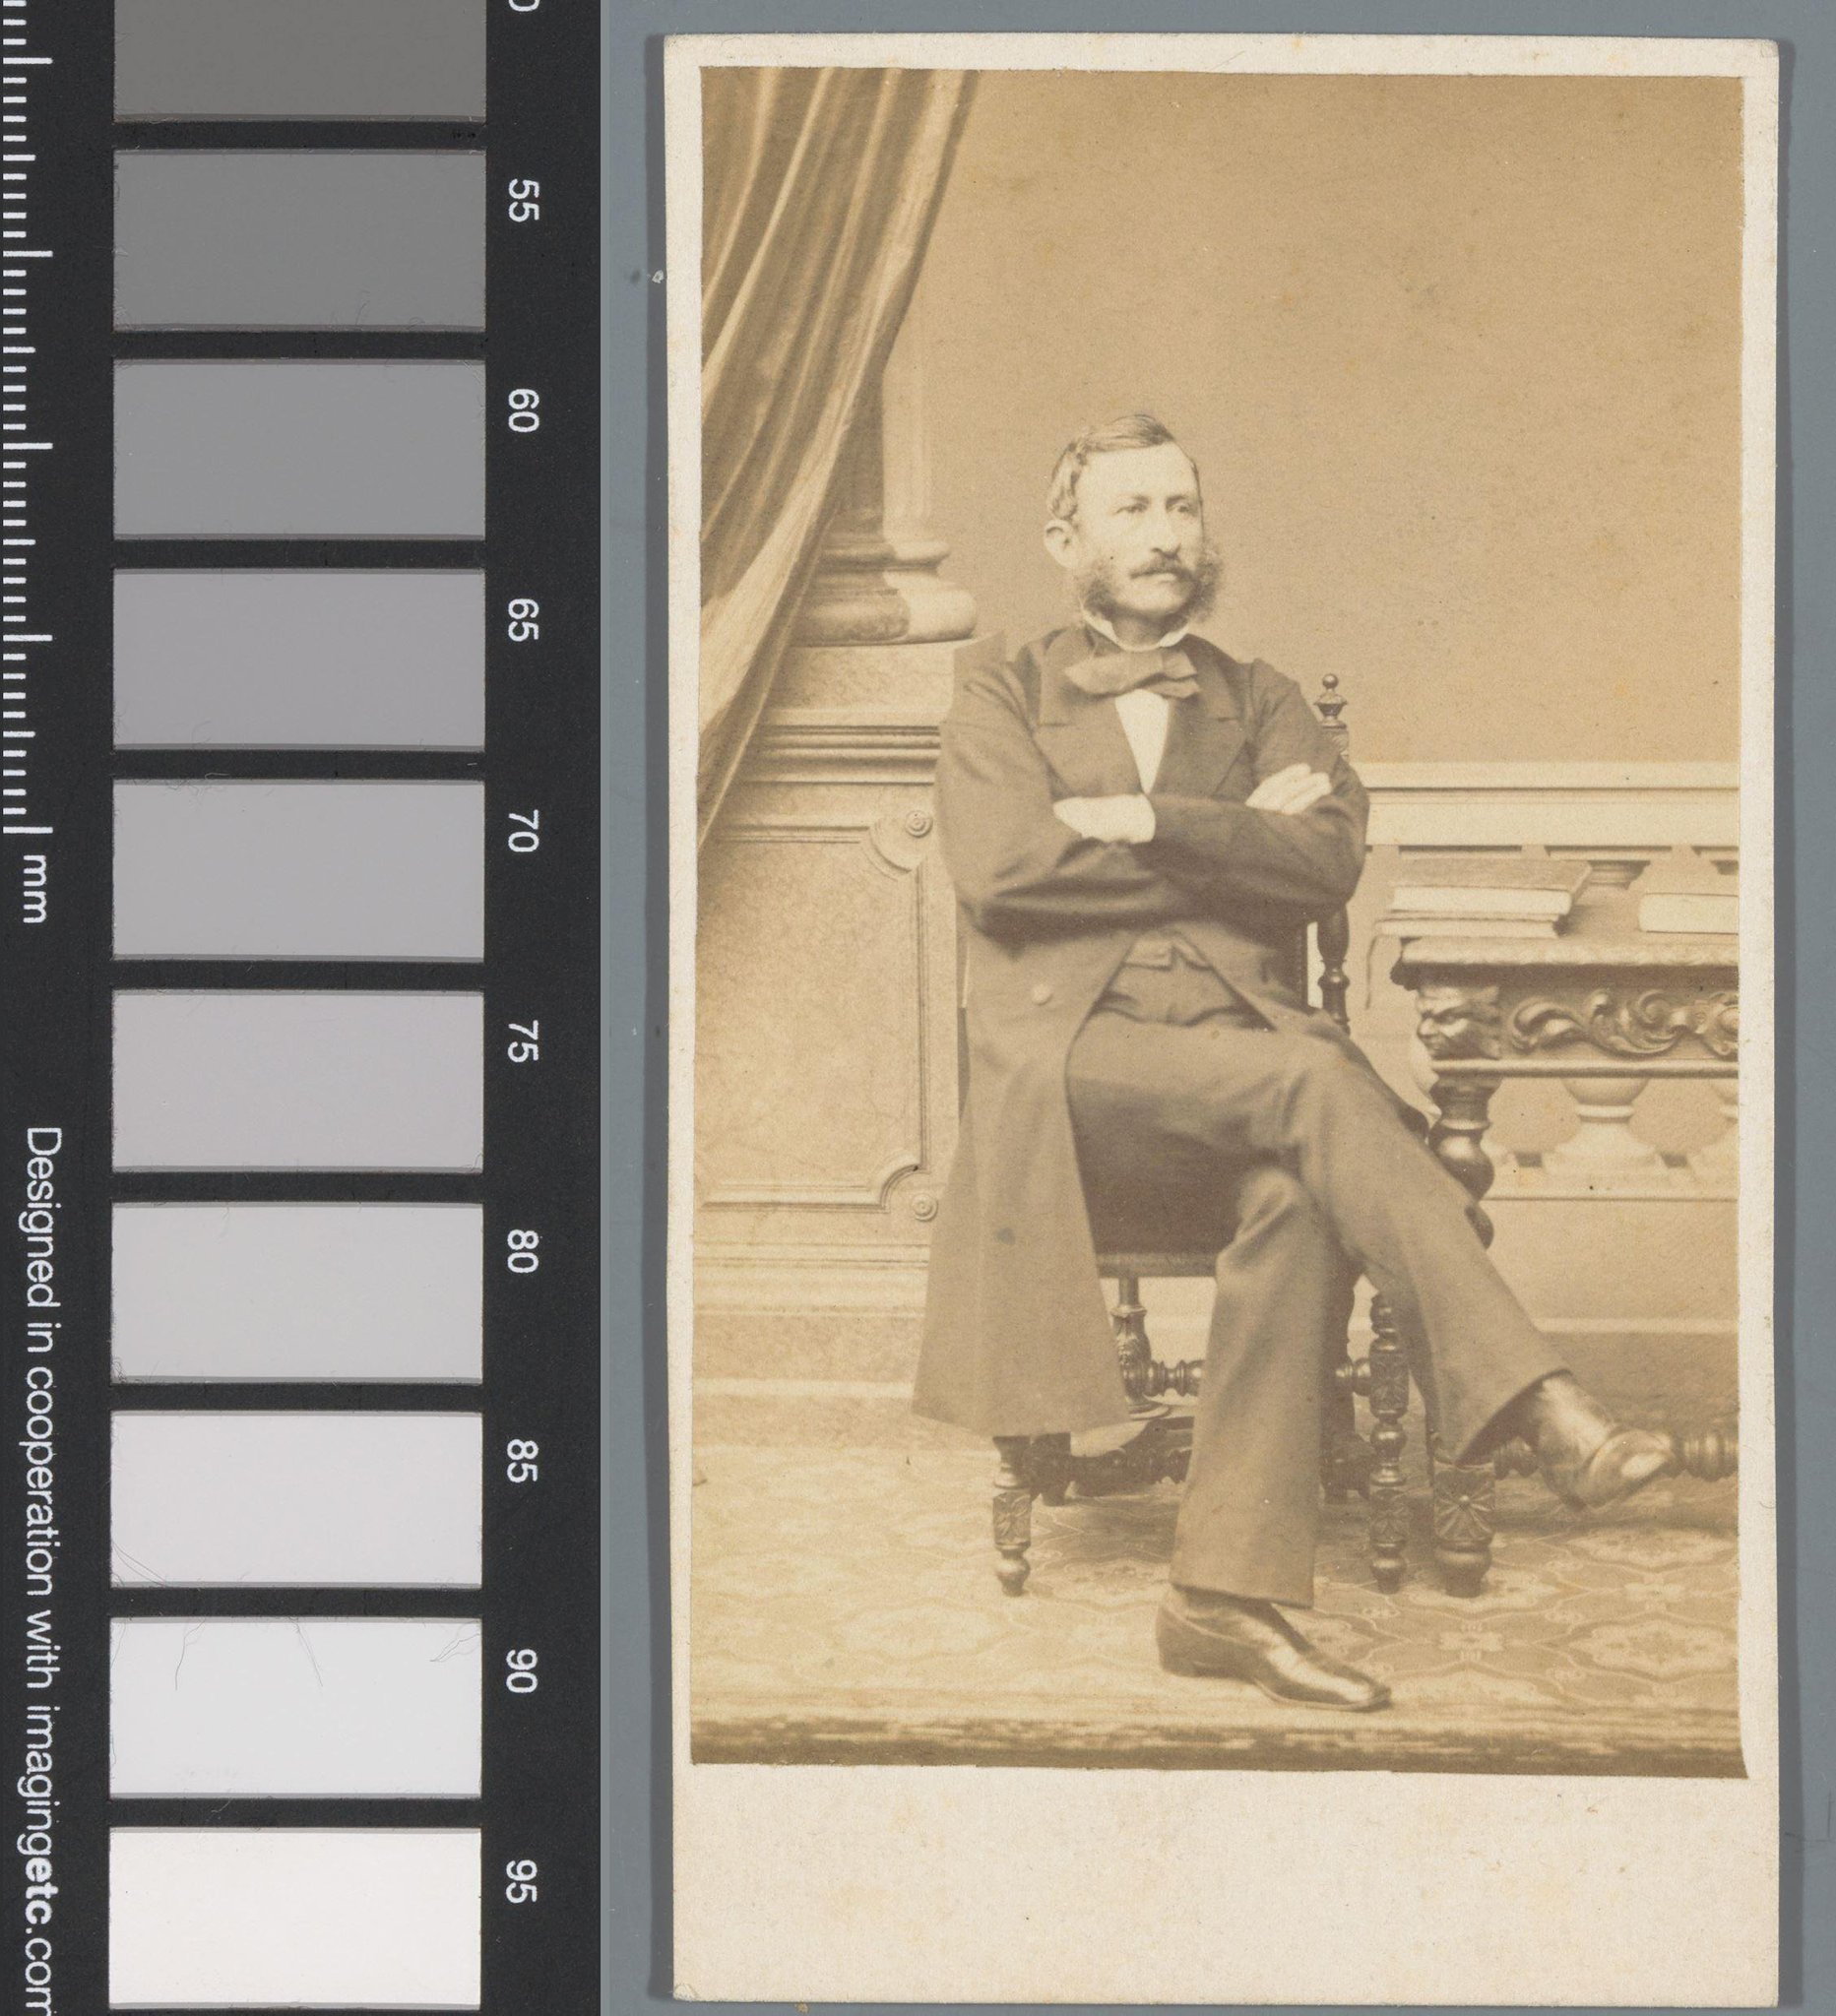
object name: photograph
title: Portret van een onbekende man aan tafel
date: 1855-1885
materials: cardboard, paper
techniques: albumen print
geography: paris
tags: adult man, historical persons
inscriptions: inscription: ‘21, RUE LOUIS-LE-GRAND, au 1er étage./ E. DEFONDS-BOUSSETON & Cie./ Peintres et Photographes/ Cartes de visite à 10f la douzaine/ Photographie 15f Aquarelle 25./ Peinture à l'huile 35f a 50f tout encadrée/ Bien faire à des Prix abordables à tout le/ monde ce que ne peuvent faire certaines/ maison, dont les énormes frais sont toujours/ au détriment du client, tel est le but que/ nou nou proposons et dont nous garantis-/ sons toujours le résultat./ Lith: [...] & Cie Peindre Caise E.’